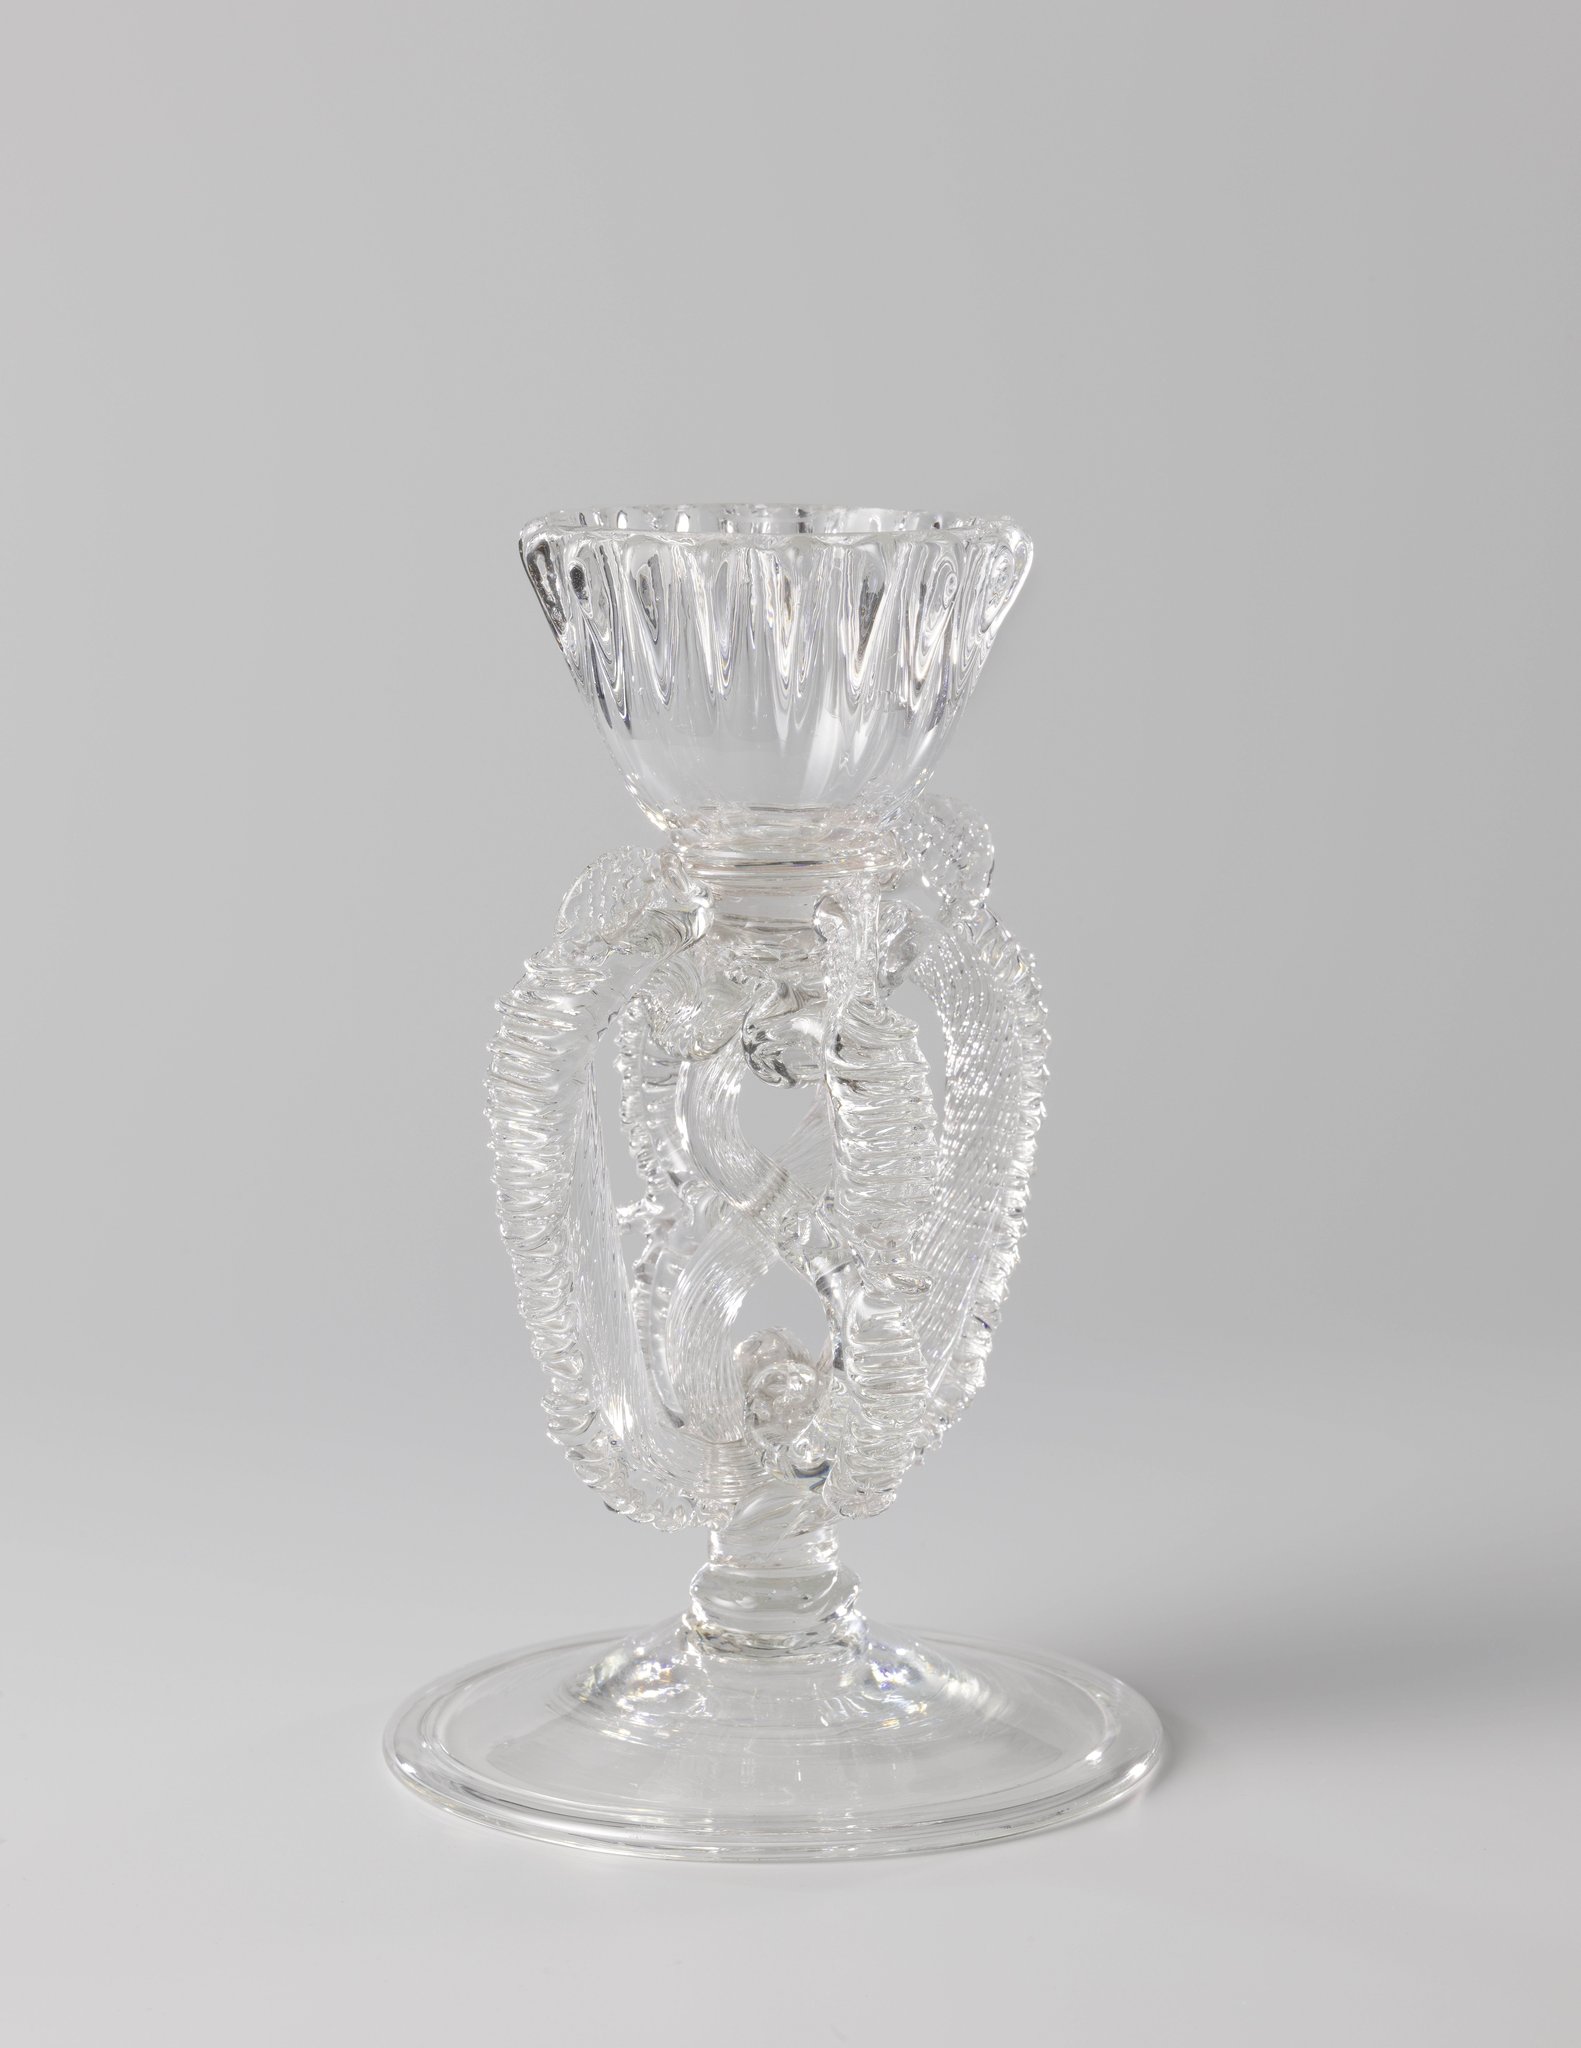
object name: sweetmeat glass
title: Slangenglas met afgeslepen kelk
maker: Anonymous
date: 1690-1700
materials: glass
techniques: glassblowing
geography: england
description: Conische voet met omgeslagen rand. De stam opgebouwd uit een geribde draad, gebogen in de vorm van een acht, met twee maal twee haaks op elkaar staande vleugels van geribde en getordeerde draden, afgezet met een geknepen kamornament. Verticaal geribde kelk, deel van de kelk is afgesplepen.